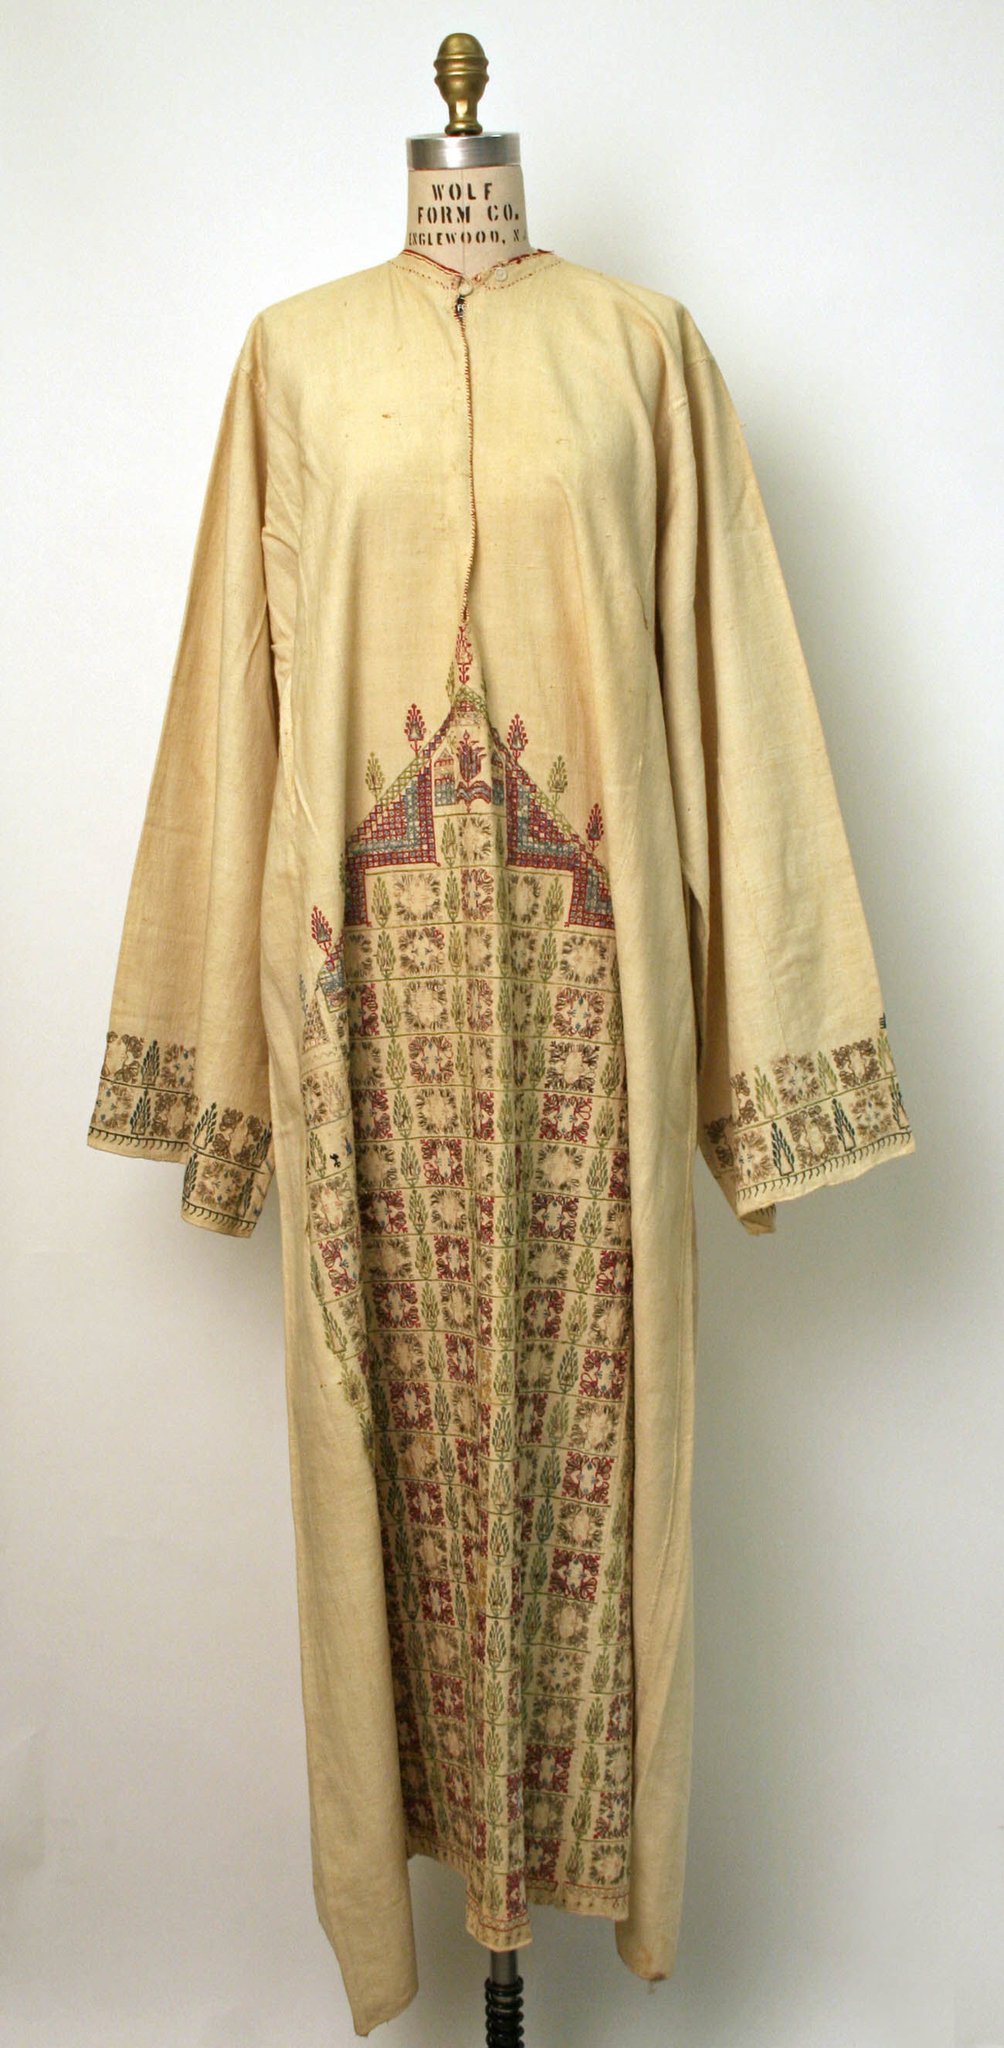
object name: dress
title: Festive Dress from Qalamun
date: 1901-1933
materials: cotton, metal thread, silk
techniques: embroidery, weave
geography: syria